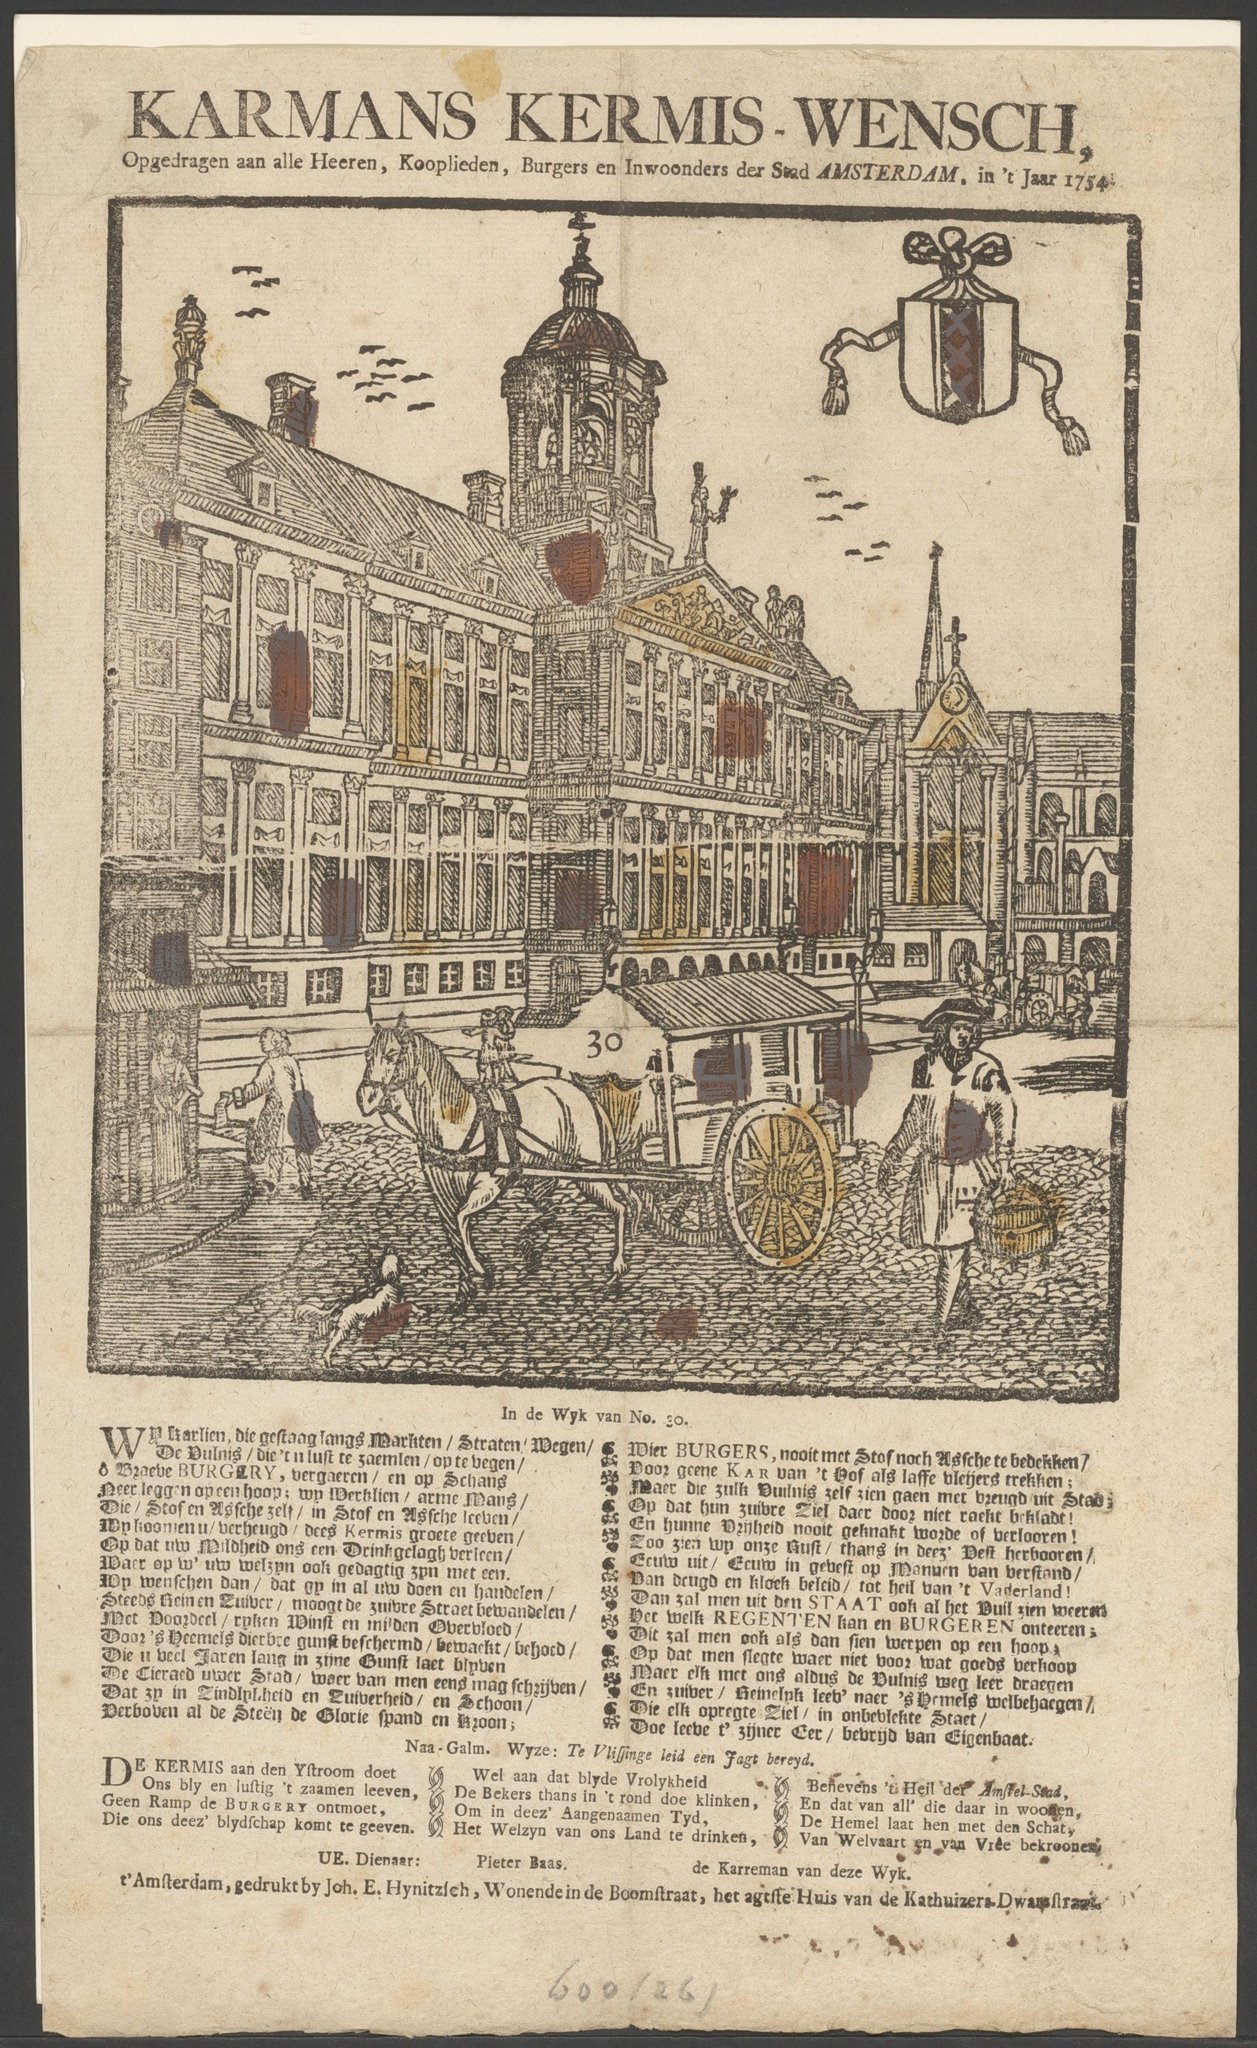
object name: print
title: Kermisprent van de Amsterdamse karrenman voor het jaar 1754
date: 1754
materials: paper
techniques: hand coloring, letterpress printing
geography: amsterdam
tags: garbage collection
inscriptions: collector's mark: Lugt 1641, stamp, inscription: ‘Deze prent is zeer raer en in Holland soms voor 20-glen meer verkogt’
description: Kermisprent voor het jaar 1754 van Pieter Baas, de karrenman (askarrenman of vuilnisman) in de wijk 30, opgedragen aan de burgers van Amsterdam. Paard met askar gemerkt 30 op de Dam voor het Stadhuis. Op het blad onder de voorstelling een vers in twee kolommen met een lied in de nagalm in drie kolommen. In het vers wordt verwezen naar Daniël Raap en de orangisten. Onderwerpsrubrieken binnen de Atlas Zeden en Gewoonten: Zeden en gewoonten in engeren zin, Volksleven, Volksbladen, Nieuwjaars- en Kerstwenschen, Amsterdam.